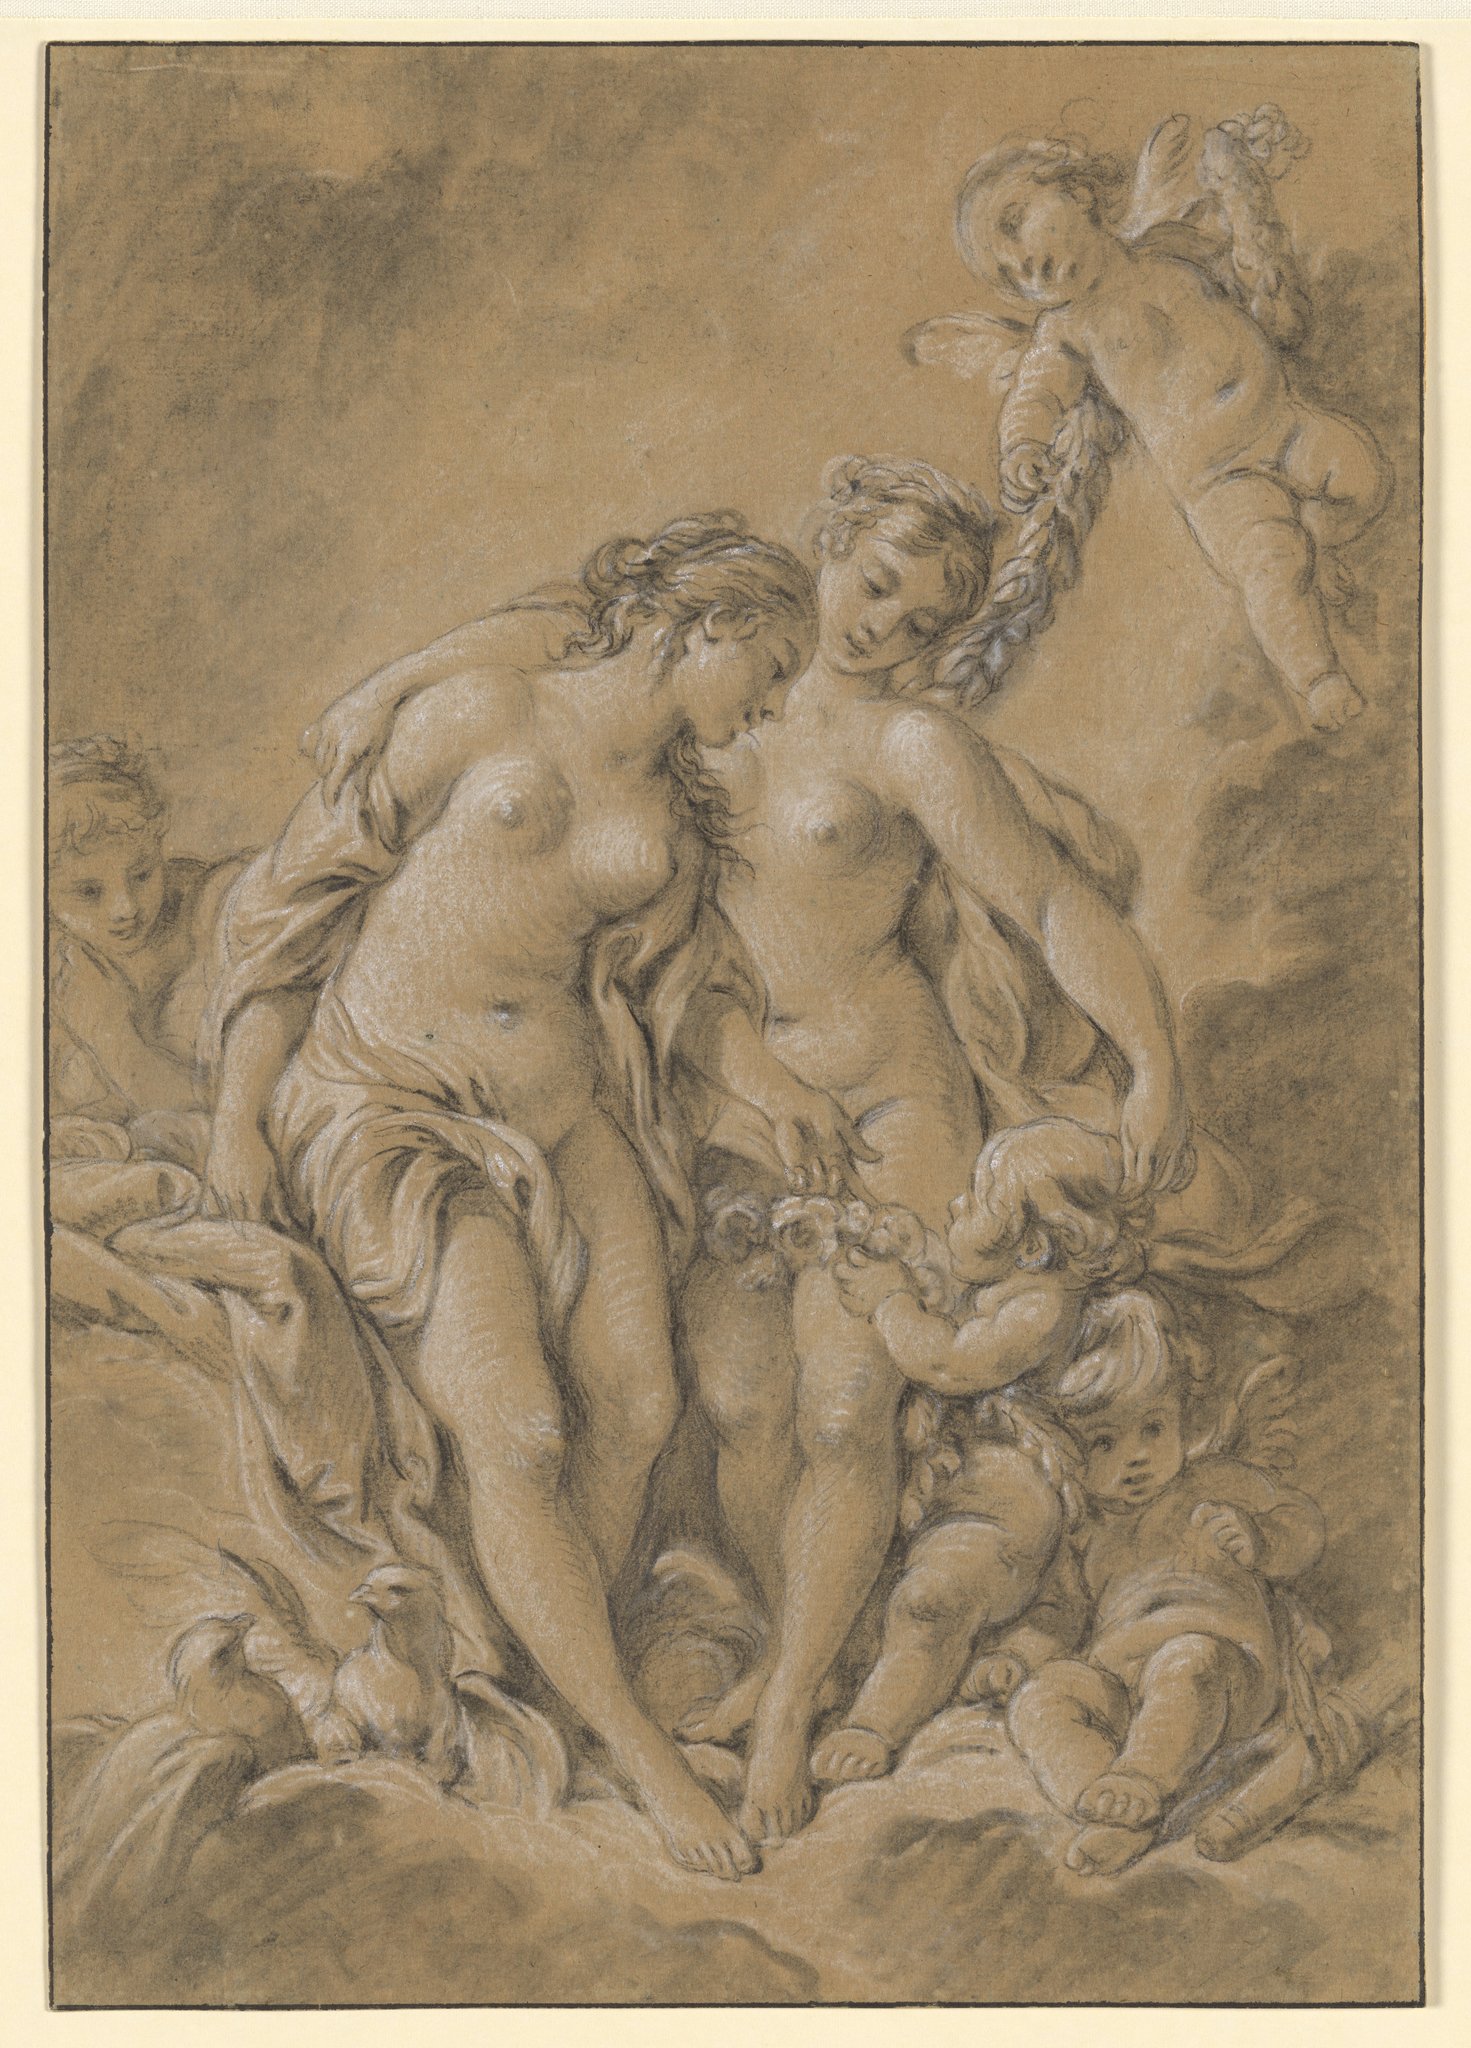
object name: drawing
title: Nymphs and Cupids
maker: françois boucher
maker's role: artist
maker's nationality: french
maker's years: 1703-1770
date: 1769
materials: chalk, paper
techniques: stumping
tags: cupid,nymphs